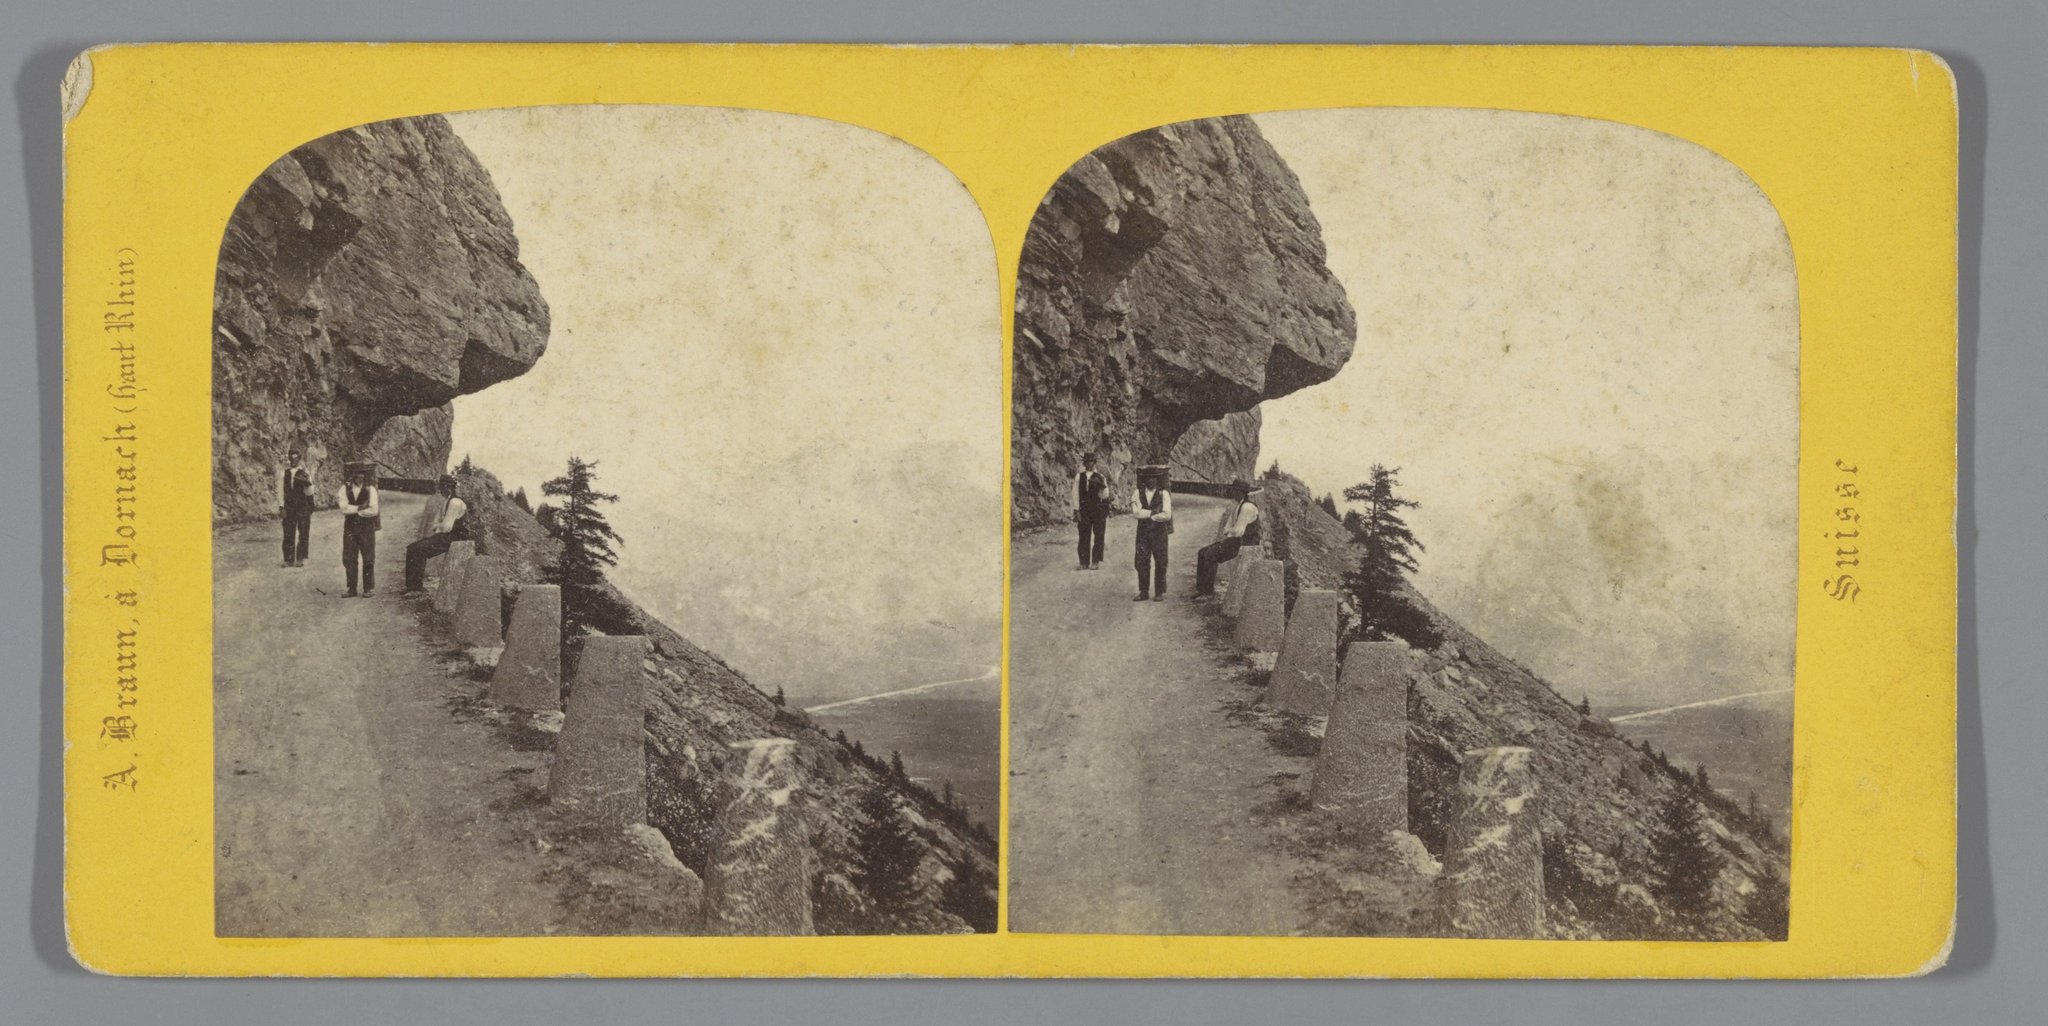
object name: stereograph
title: Suisse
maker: Anonymous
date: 1879-1889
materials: cardboard, paper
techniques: albumen print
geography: dornach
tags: passage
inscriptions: number: ‘441’, number: ‘No 5482.’, inscription: ‘Helmut Zooman/ July 1870 [?]’